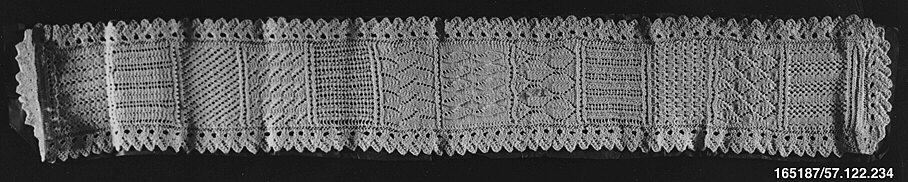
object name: sampler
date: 1801-1900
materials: wool